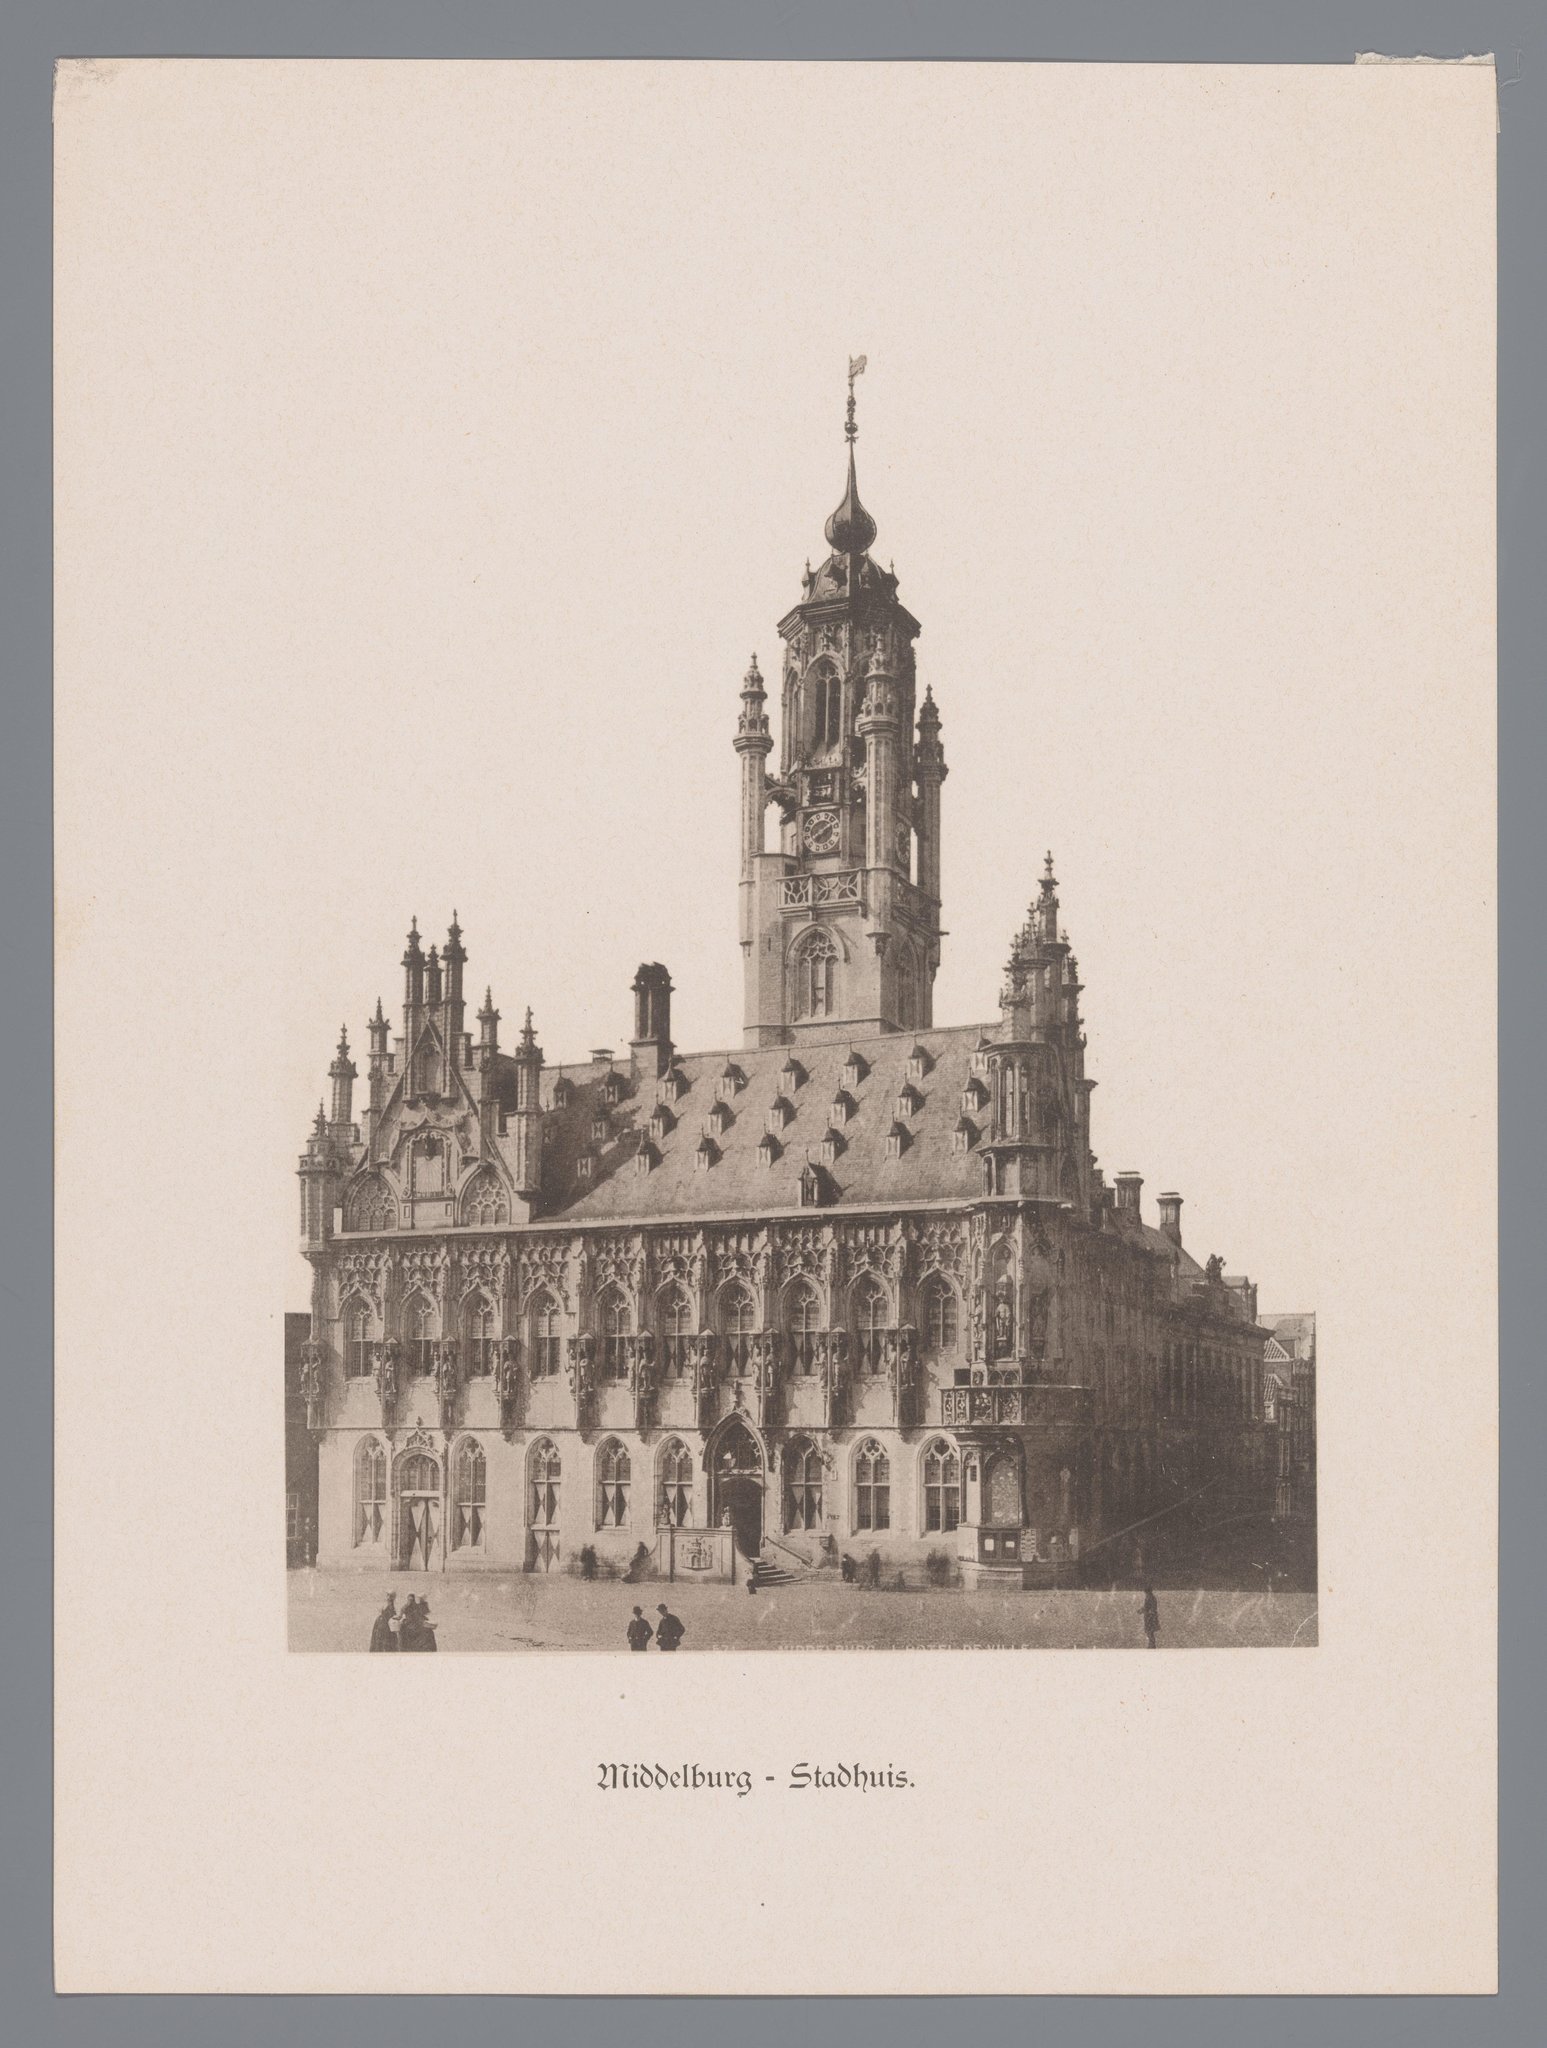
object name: photomechanical print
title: Gezicht op het Stadhuis van Middelburg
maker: Anonymous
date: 1850-1900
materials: paper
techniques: photograph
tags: townhall